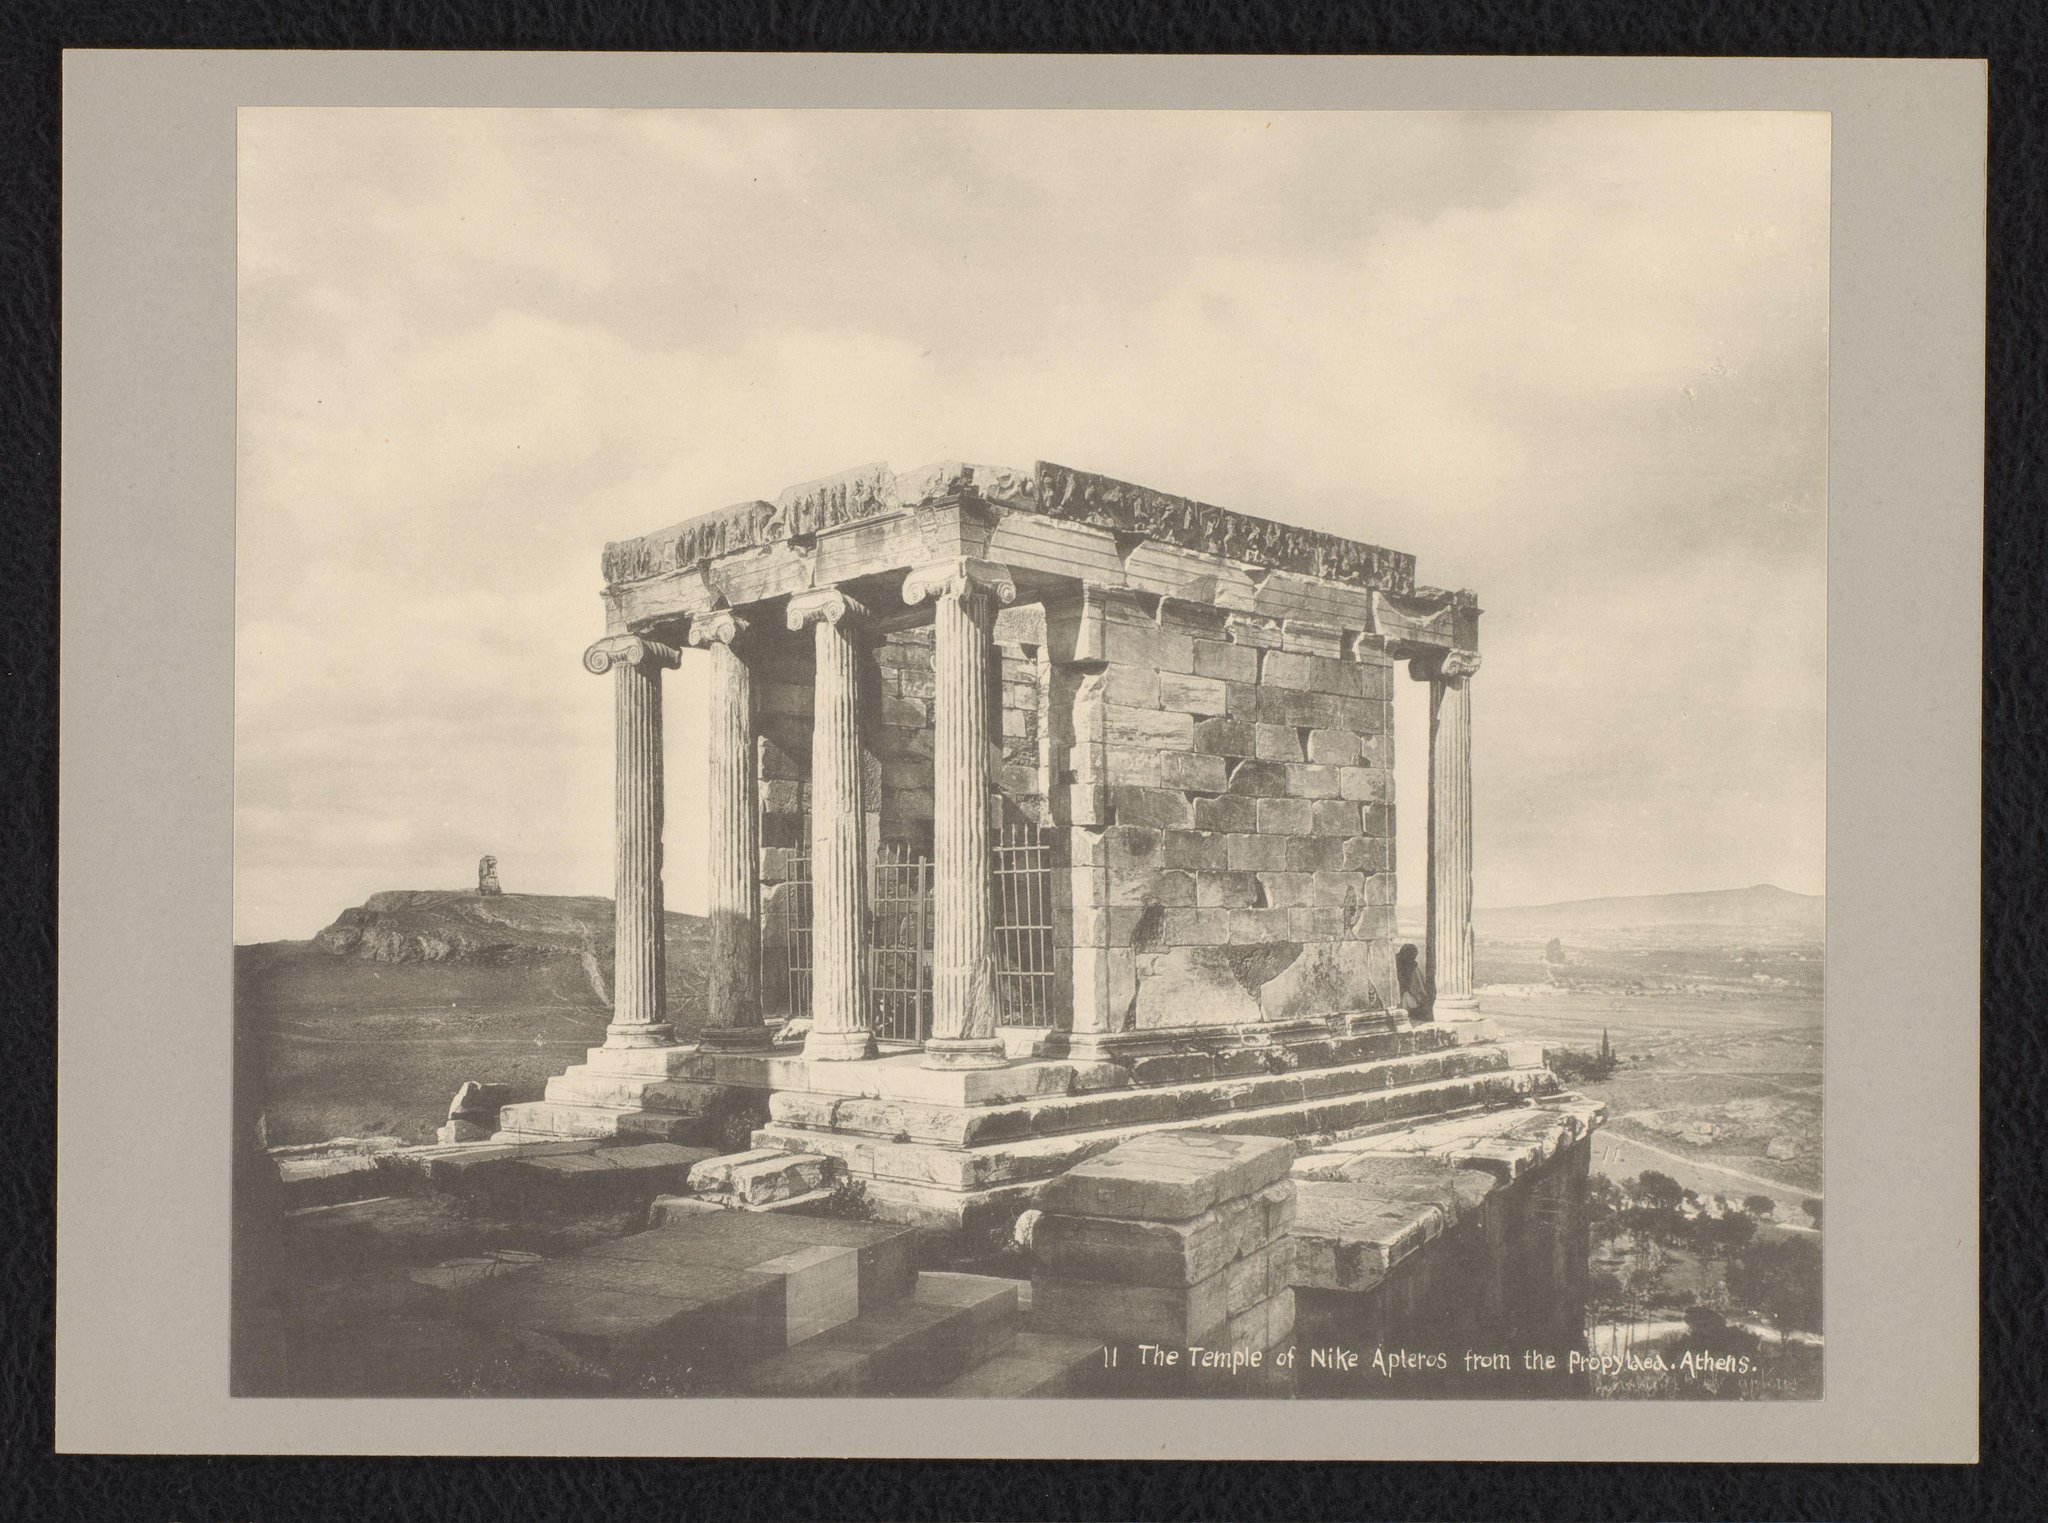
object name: photograph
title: Tempel van Nike Apteros, Athene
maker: Anonymous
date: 1895-1915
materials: cardboard, paper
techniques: photograph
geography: delphi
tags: athene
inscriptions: number: ‘23.’